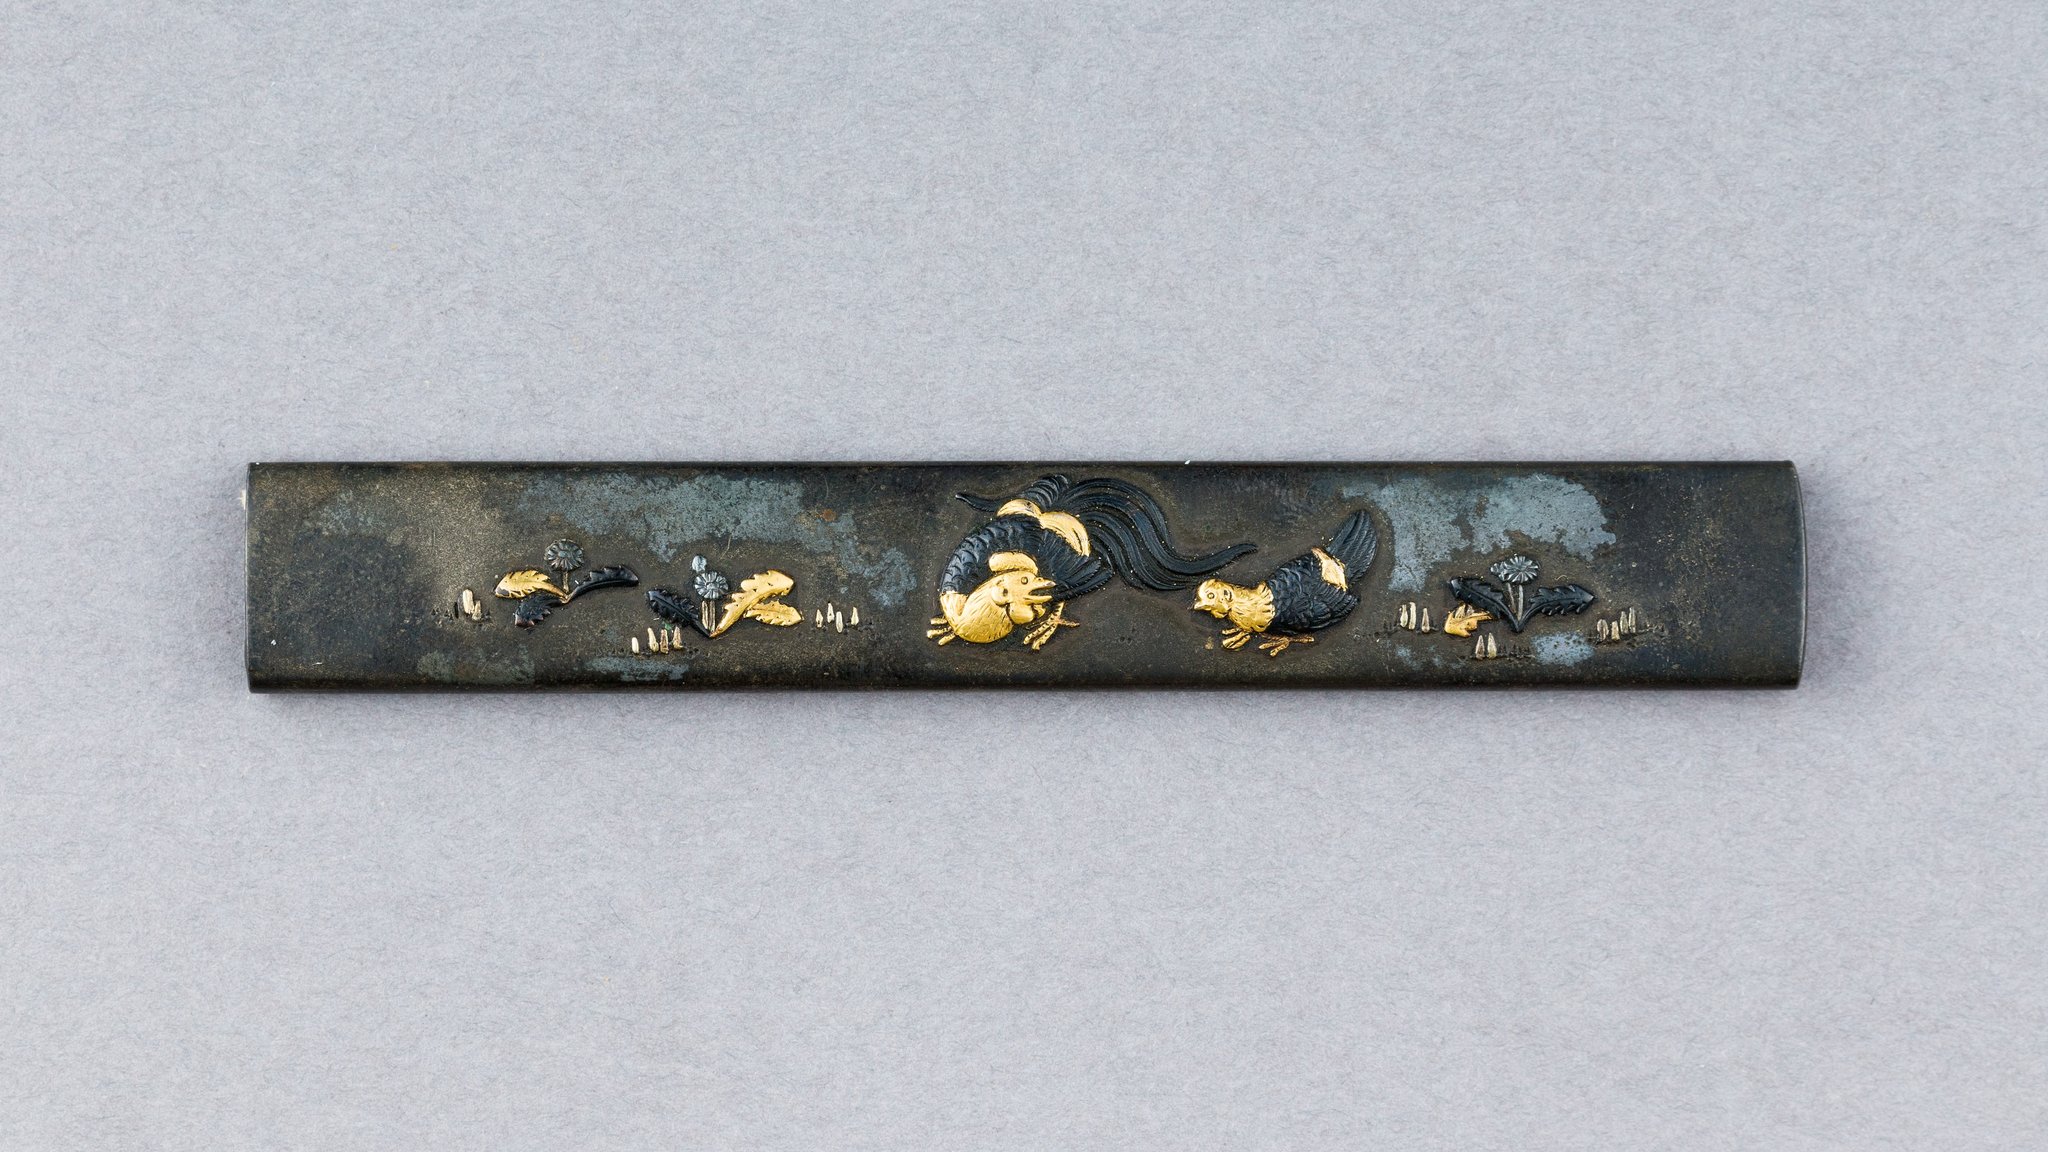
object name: knife handle kozuka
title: Knife Handle (Kozuka)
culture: japanese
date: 1615-1868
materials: gold alloy, silver alloy, gold, silver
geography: japan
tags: roosters